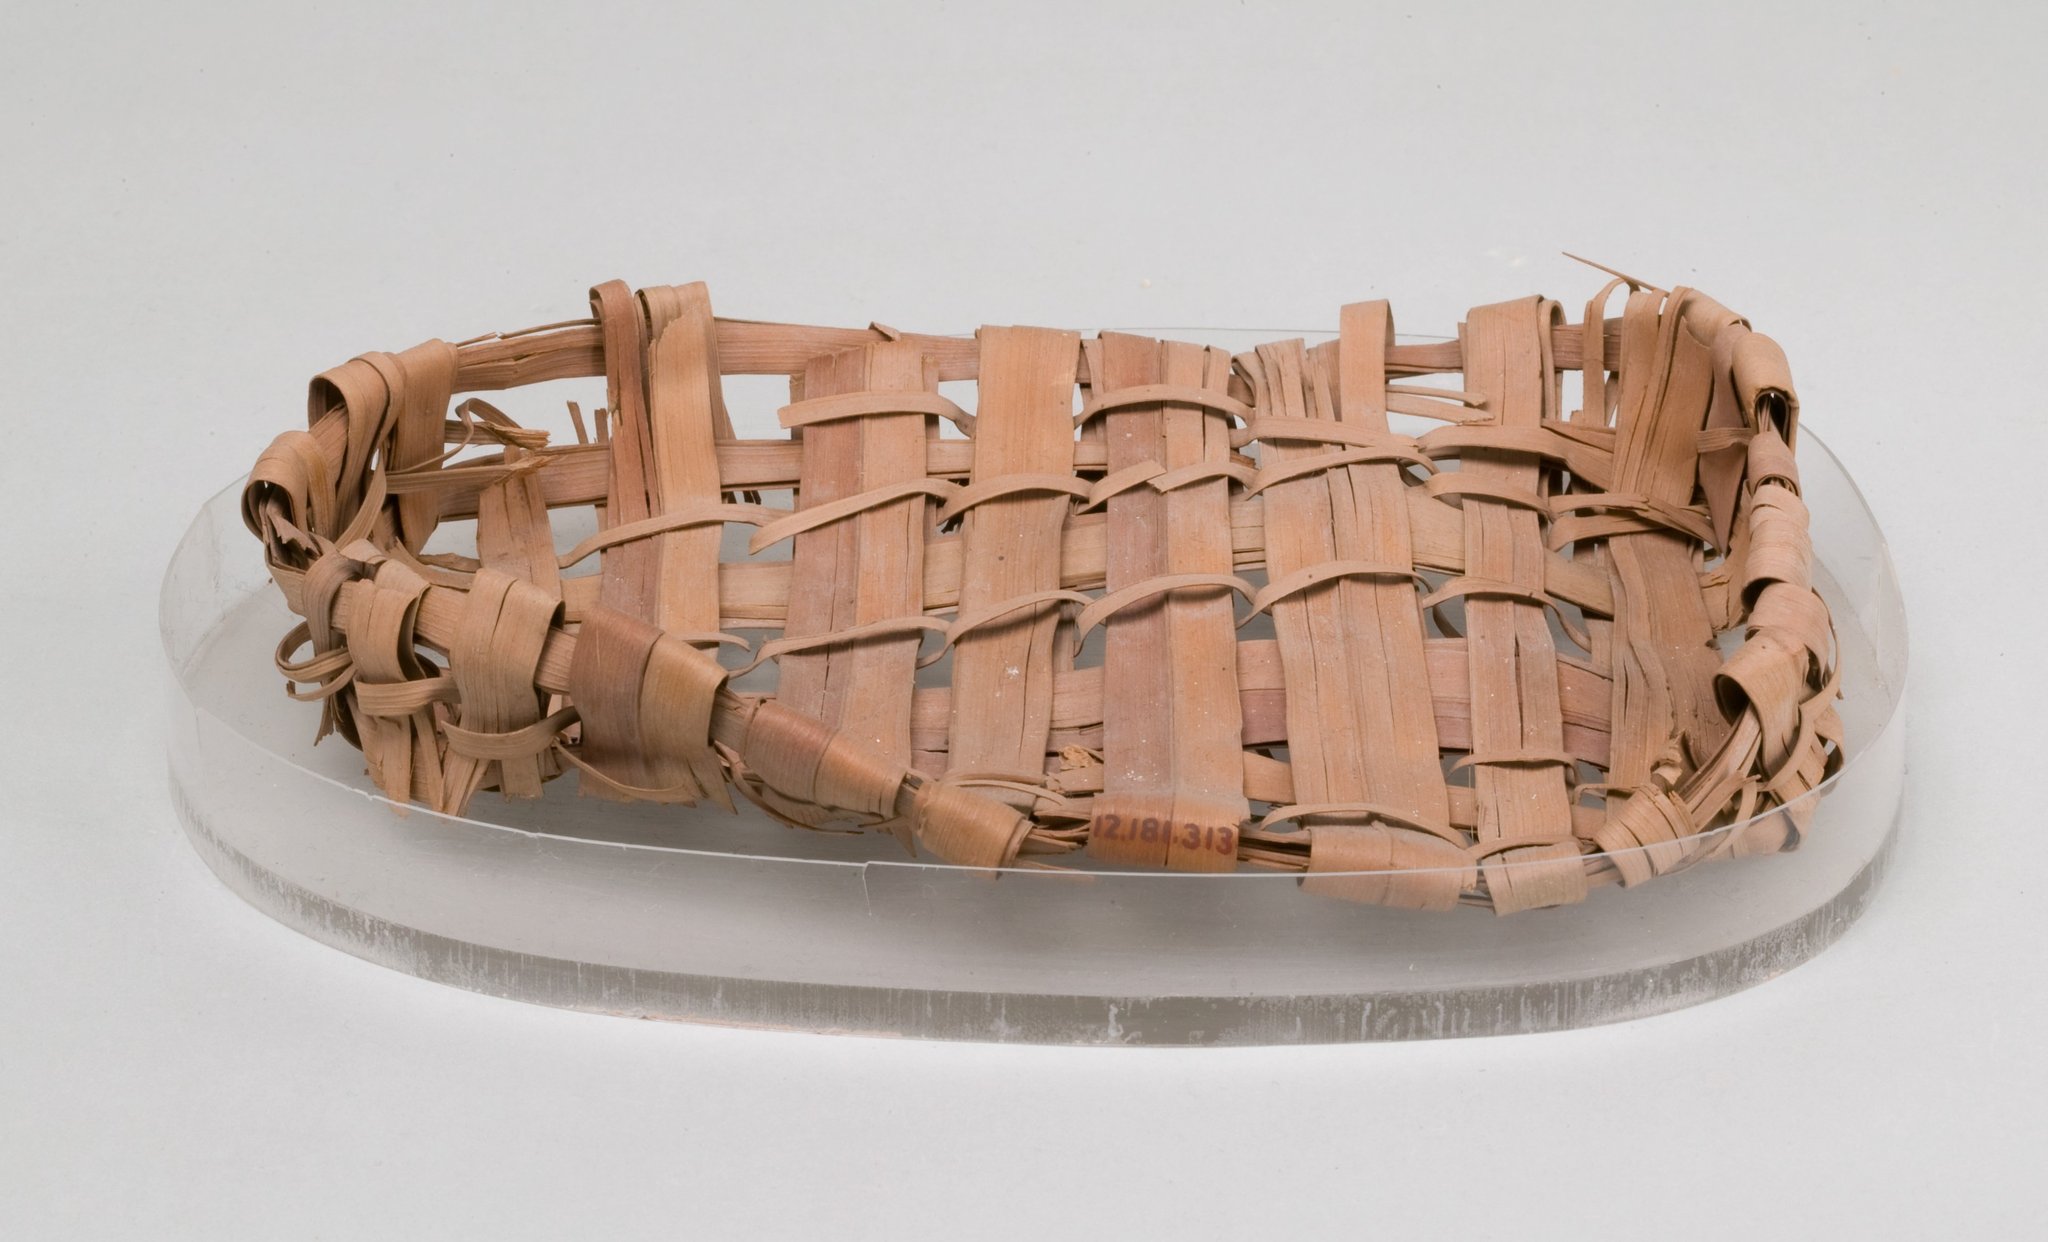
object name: basket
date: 1550-1295 BCE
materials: fiber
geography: egypt